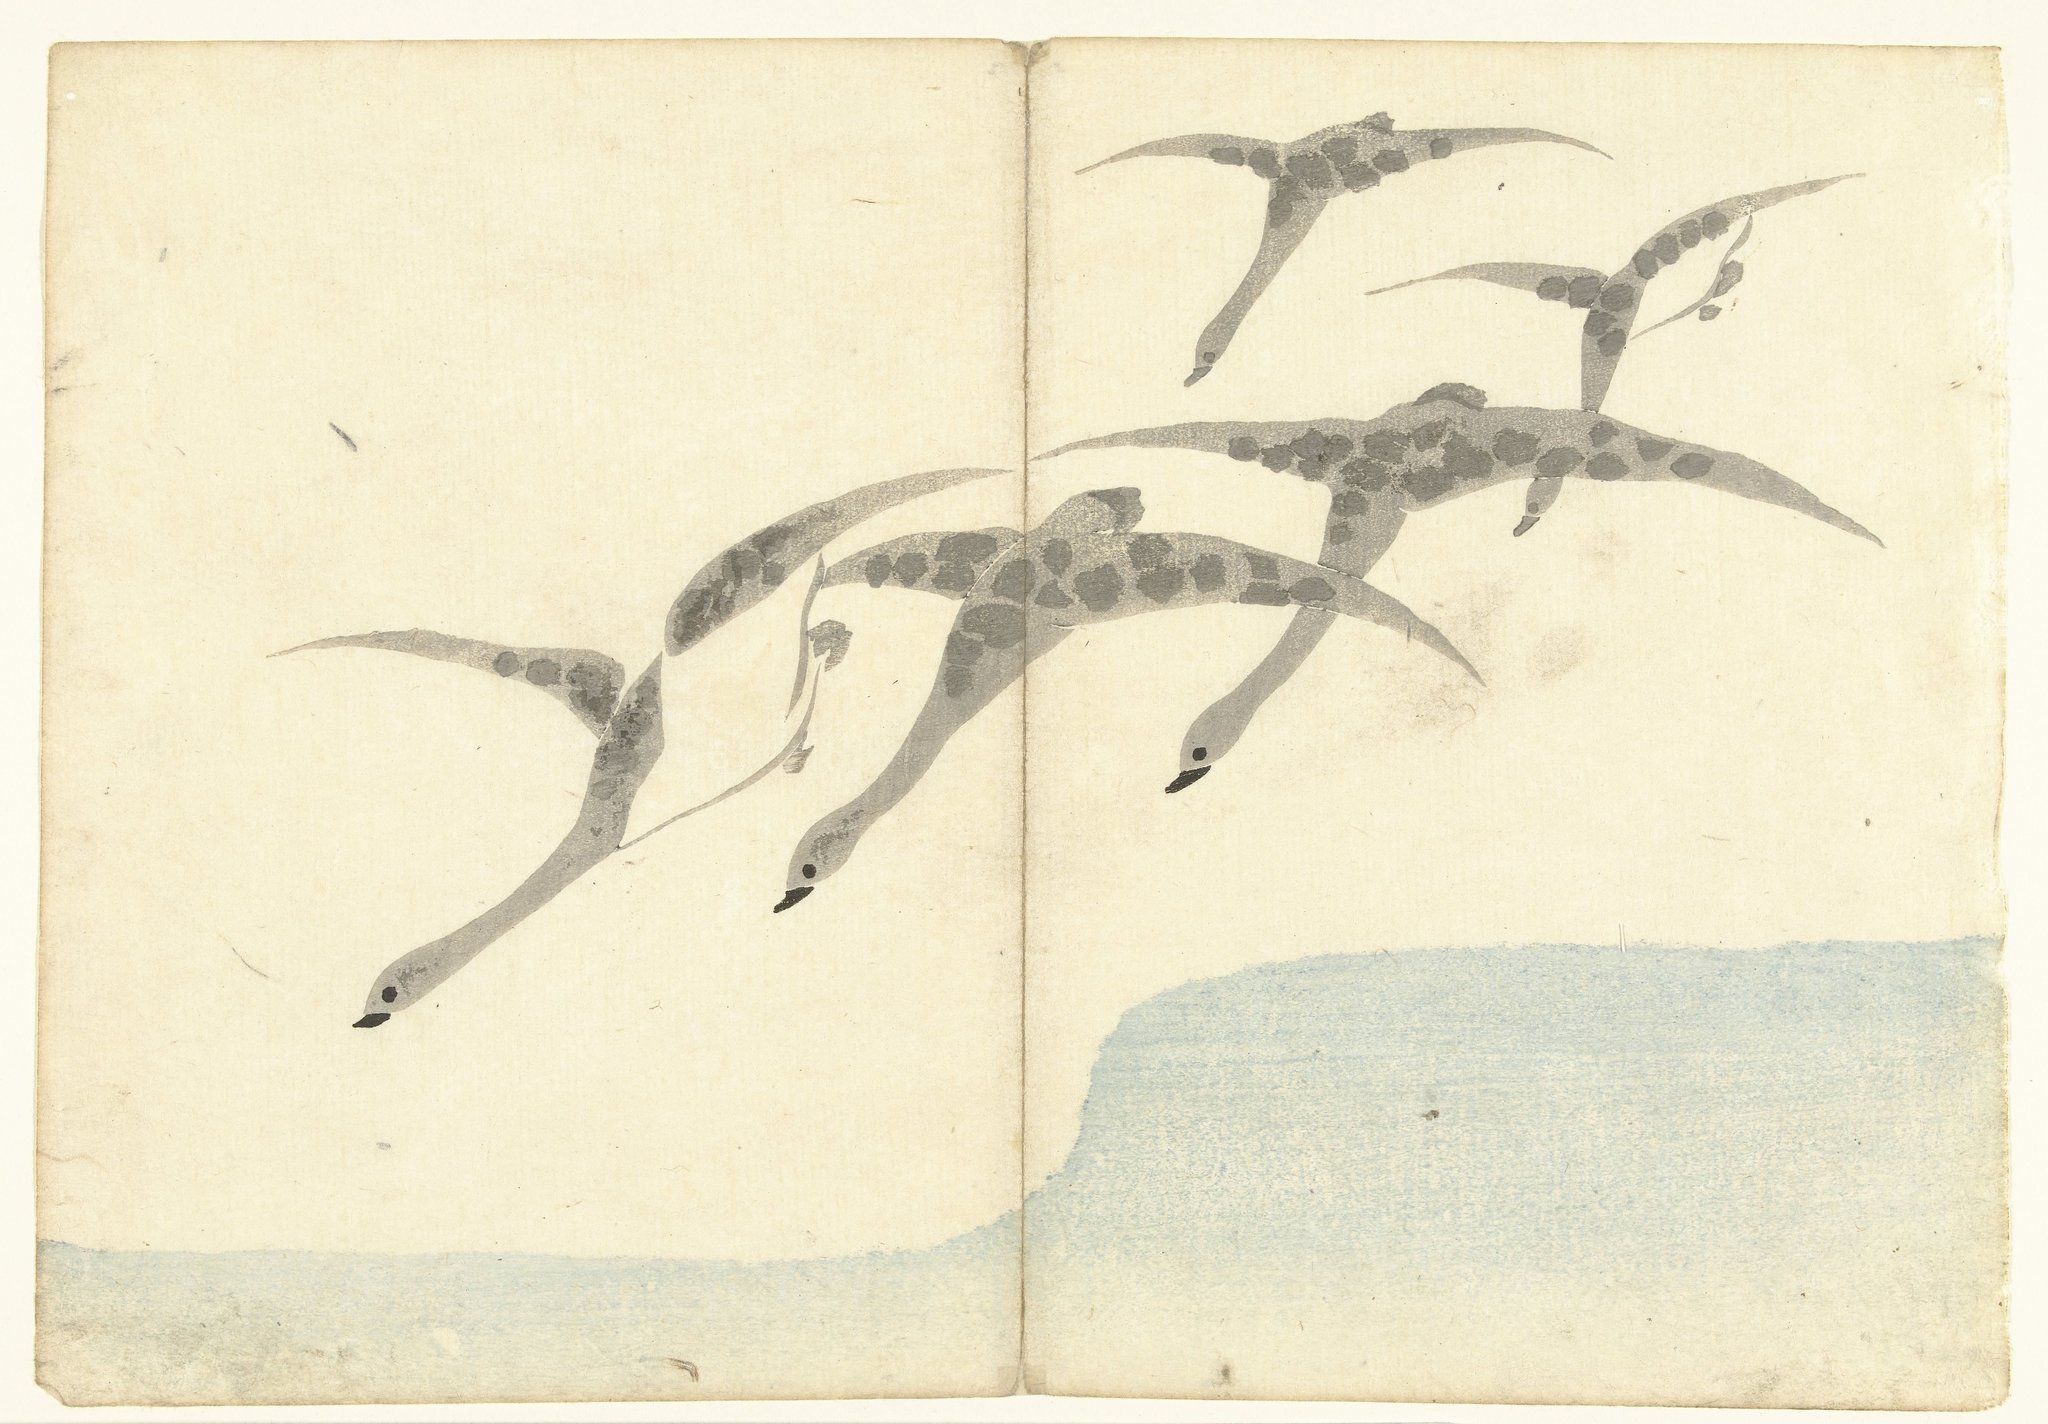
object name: print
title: Prentenalbum van Korin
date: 1826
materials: paper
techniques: woodcut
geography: edo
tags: water-birds: goose, flying